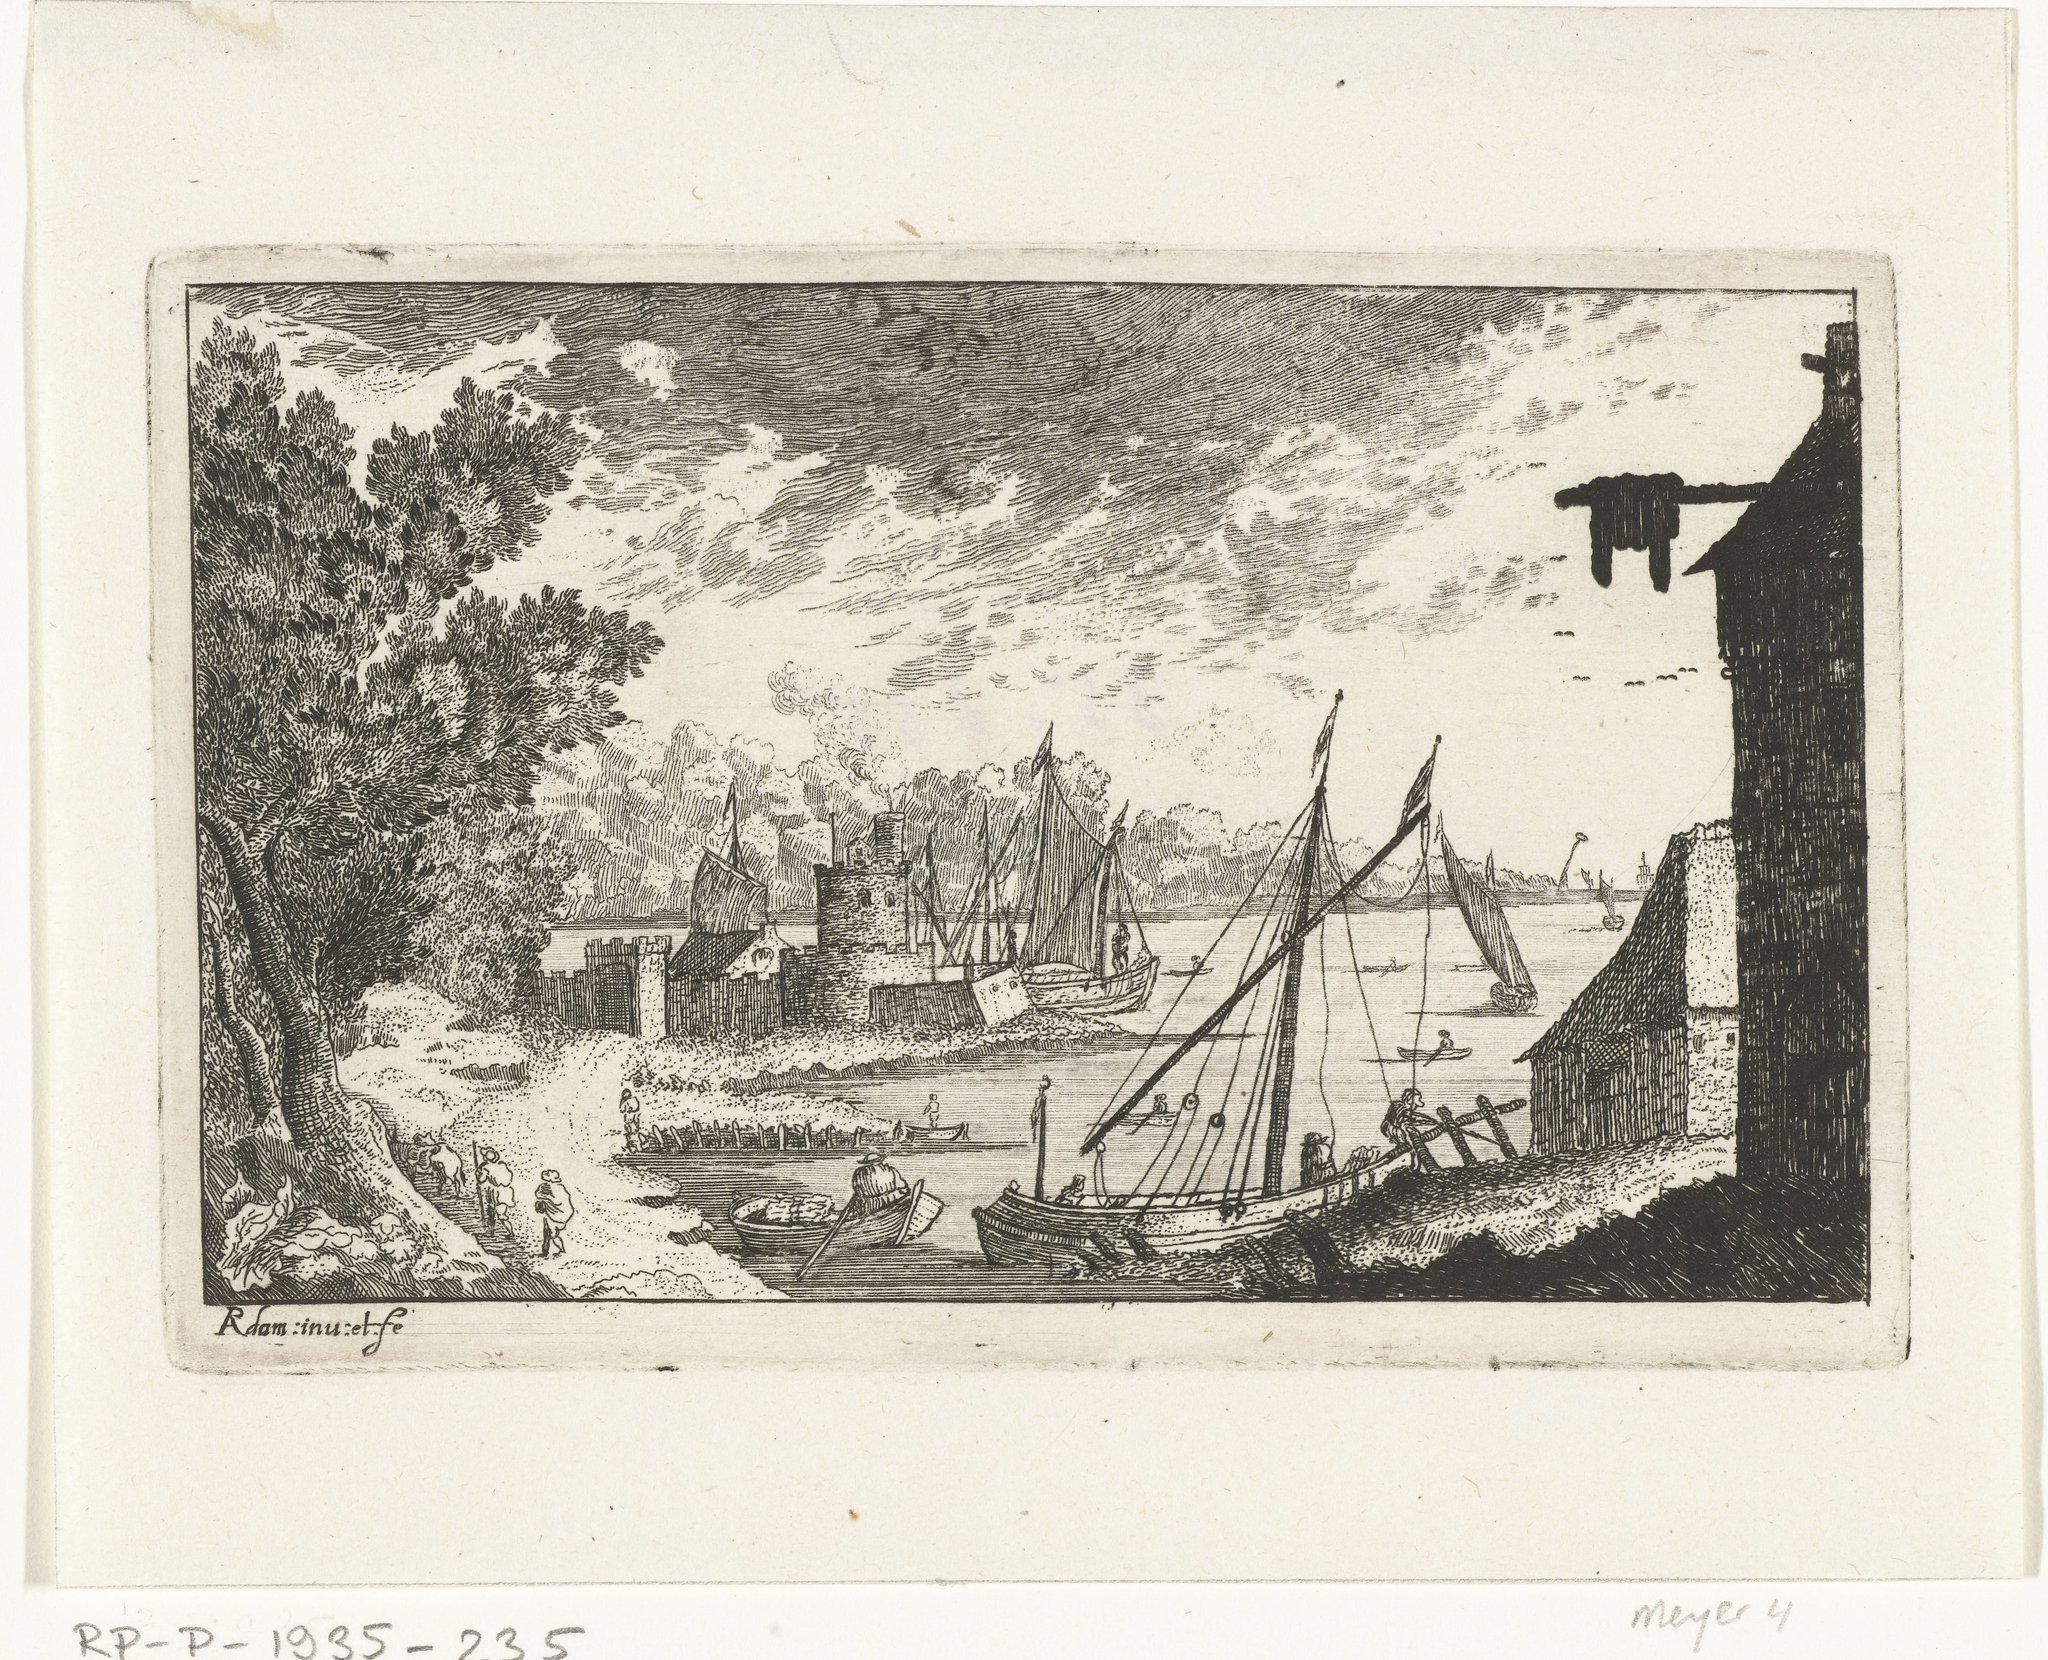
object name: print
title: Vissershaven met aanmerend schip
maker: richard adam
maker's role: print maker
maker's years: 1644-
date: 1654-1693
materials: paper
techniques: etching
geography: netherlands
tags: harbour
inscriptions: collector's mark: Lugt 2760, collector's mark: Lugt 2228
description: Vissershaven met boten, op de voorgrond een roeiboot en een aanmerend schip met gestreken zeilen. Links drie wandelaars. Op de achtergrond een toren bij de haveningang.